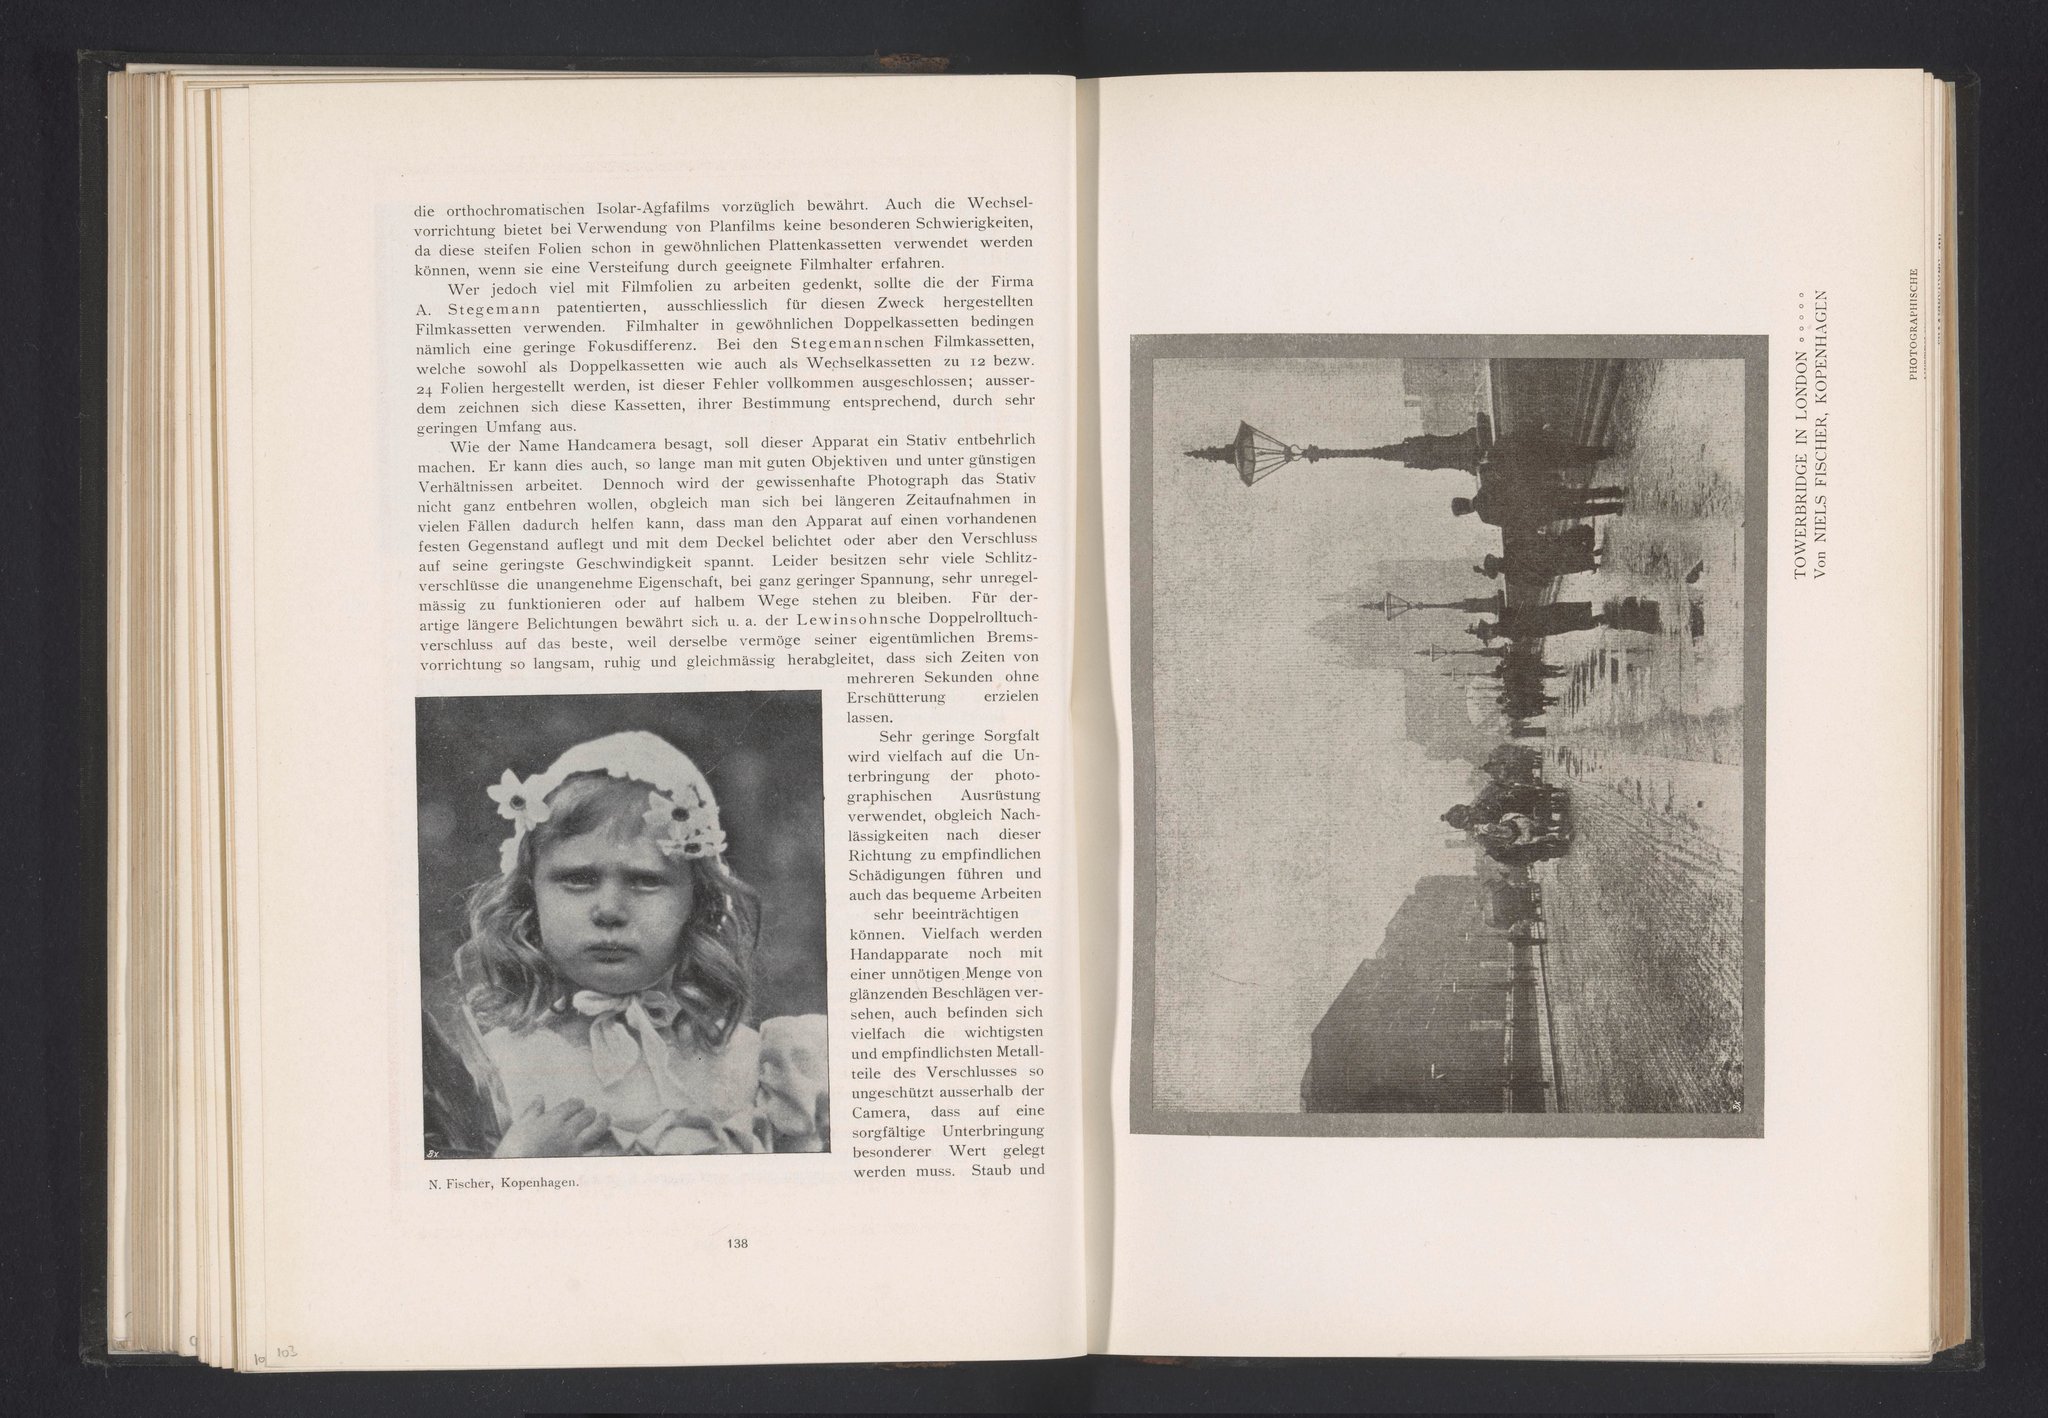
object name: page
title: Portret van een onbekend meisje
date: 1898-1903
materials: paper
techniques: autotype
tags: historical persons - bb - woman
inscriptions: inscription: ‘Kopenhagen’, monogram: ‘BX’